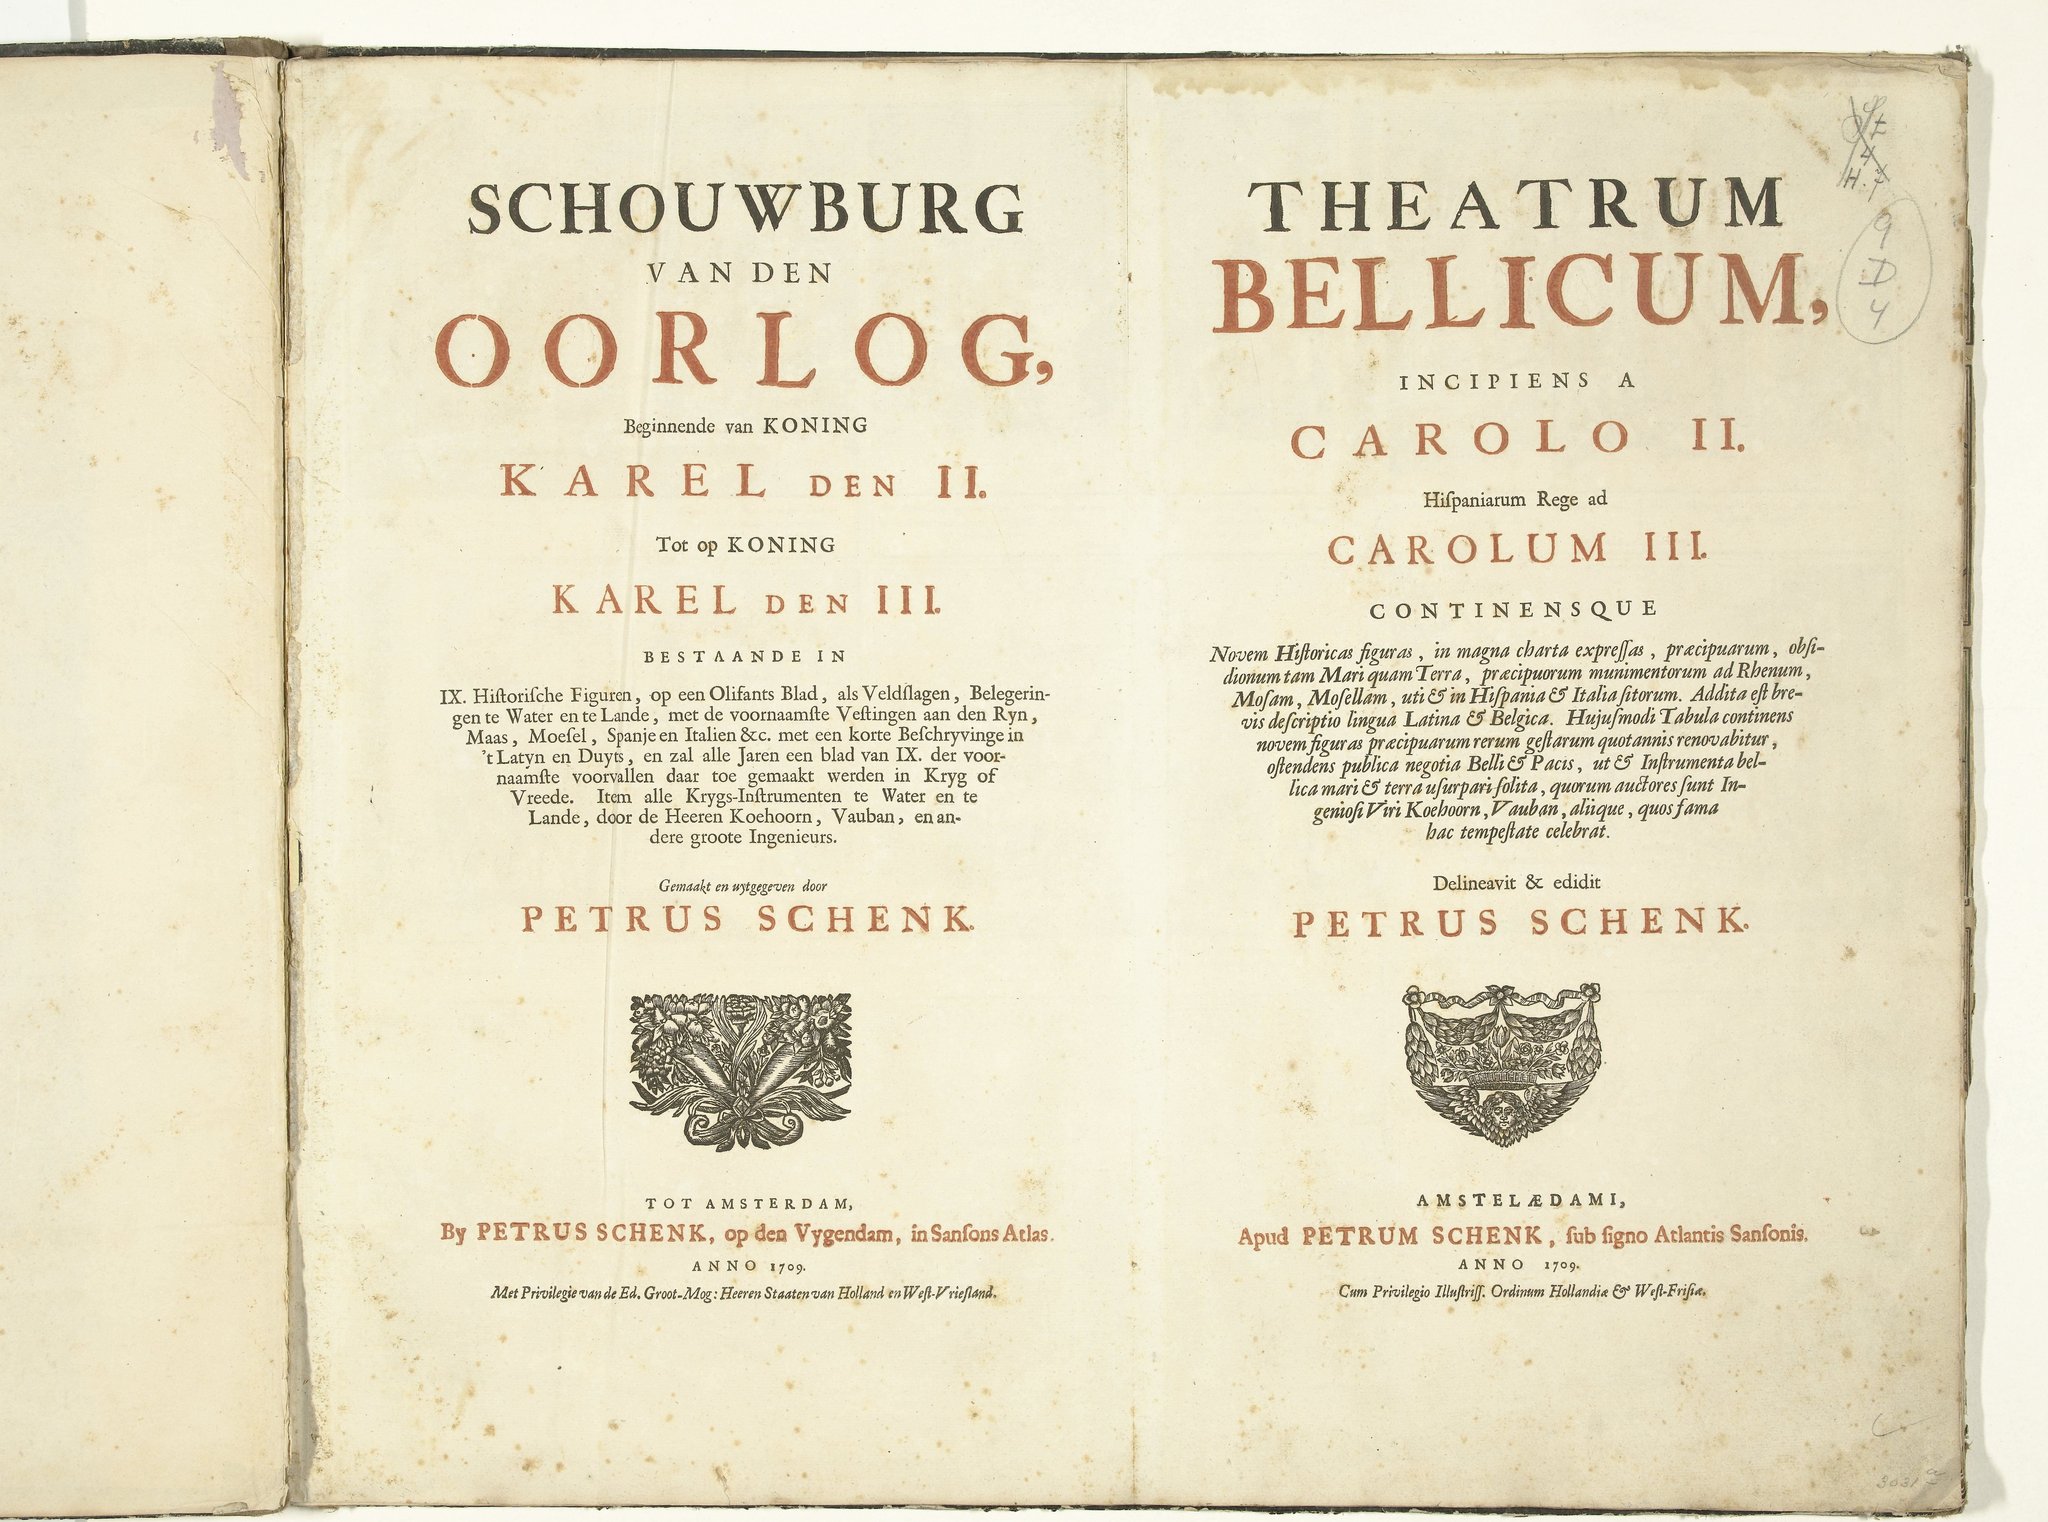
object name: titelblad, titelpagina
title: Schouwburg van den Oorlog, Beginnende van Koning Karel den II. Tot op Koning Karel den III. Bestaande in IX. Historische Figuren op een Olifants Blad, als Veldslagen, Belegeringen te Water en te Lande, met de voornaamste Vestingen (...)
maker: pieter schenk (i)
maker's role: print maker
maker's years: 1660-1711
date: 1709-1710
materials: paper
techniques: letterpress printing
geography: amsterdam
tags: spaanse successieoorlog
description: Titelpagina gedrukt in zwart en rood in: Schouwburg van den oorlog (editie van 1709), het prentwerk met de gebundelde reeks van 18 platen over de Spaanse Successieoorlog.